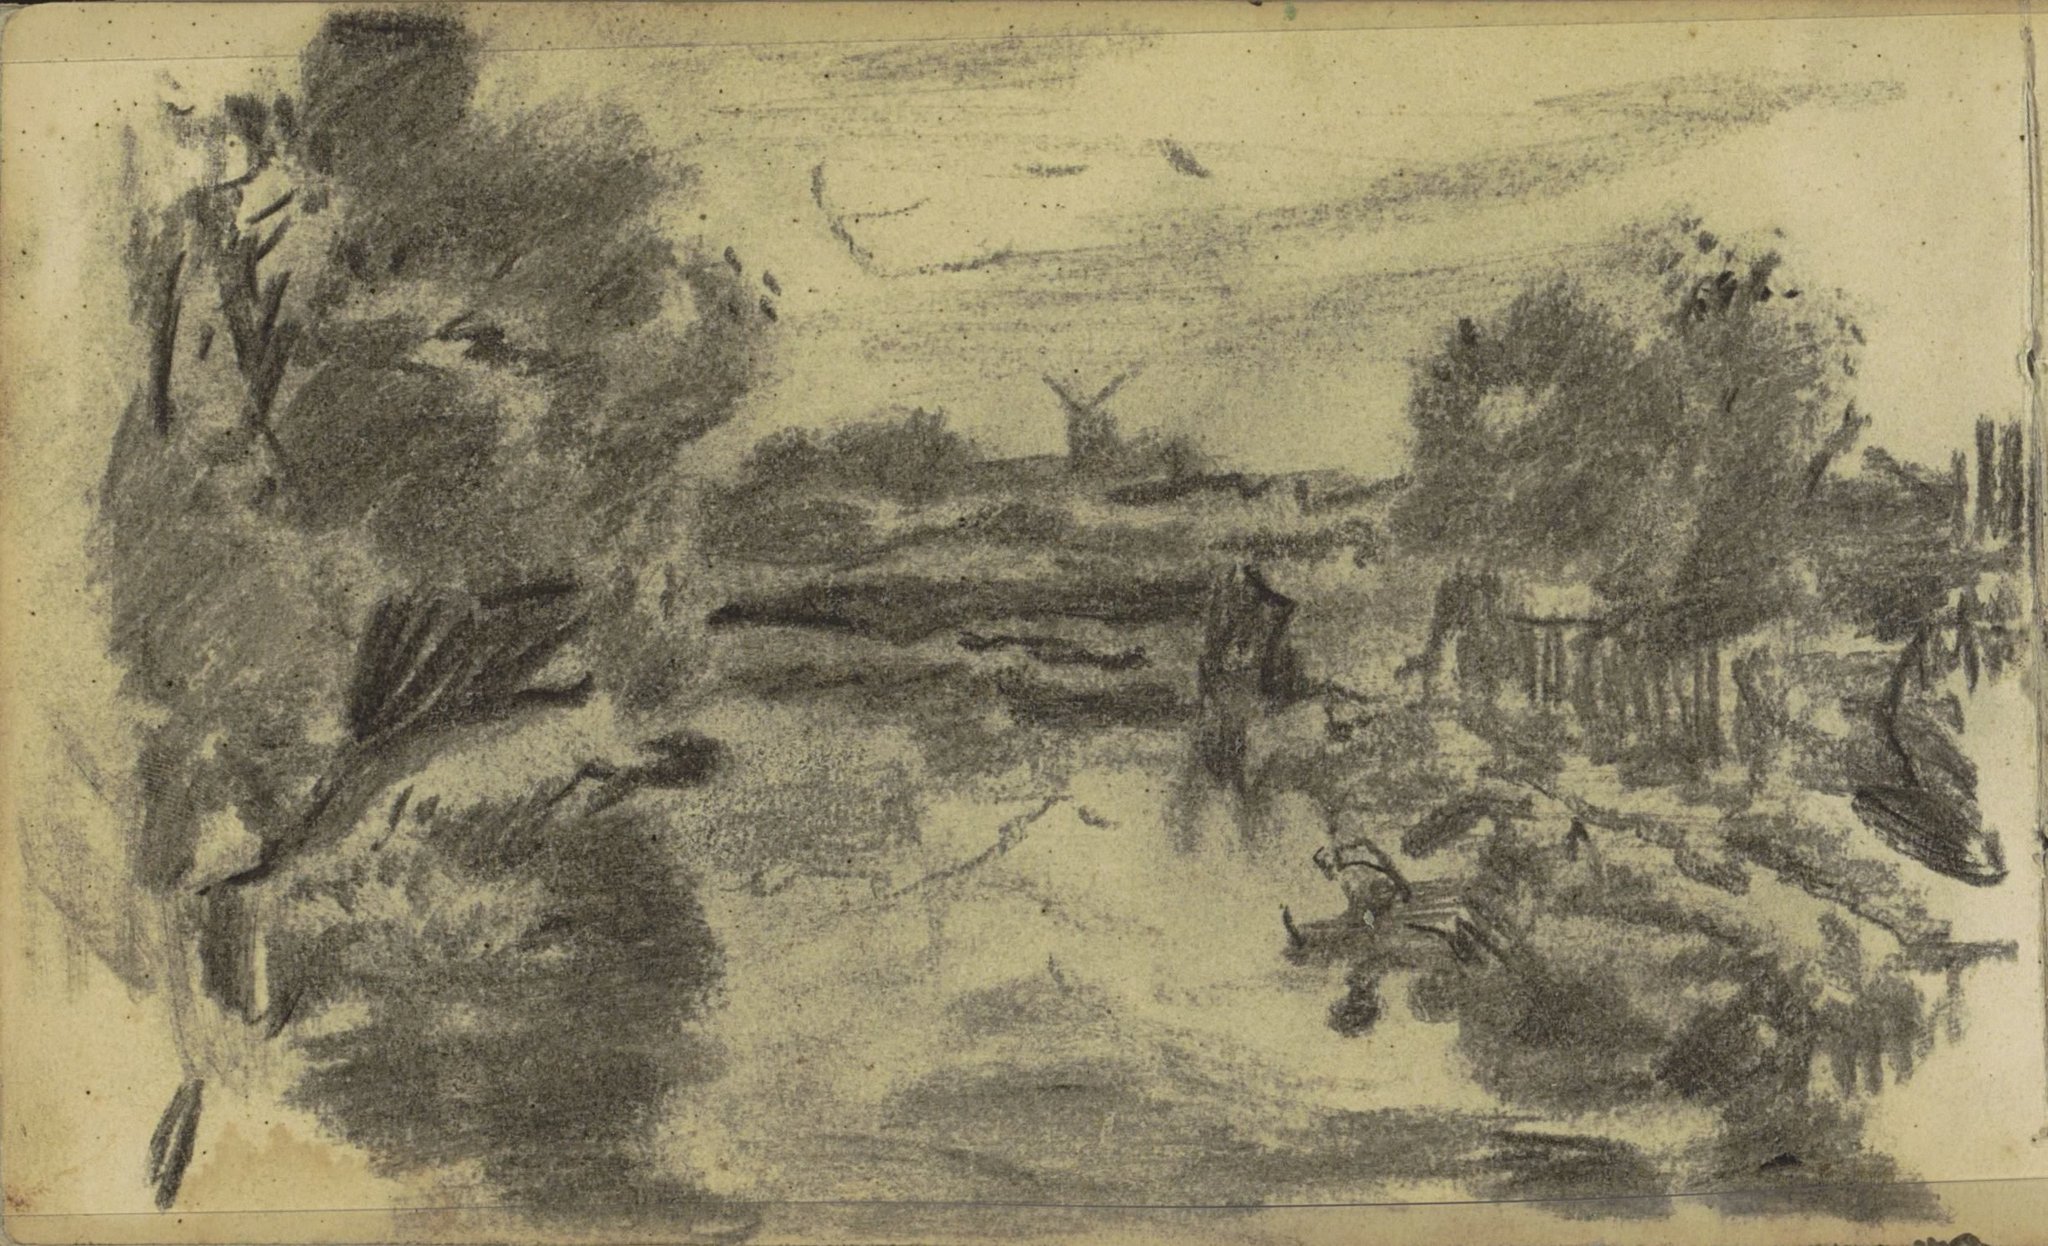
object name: sketchbook leaf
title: Landschap met water en een molen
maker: jozef israëls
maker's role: draughtsman, painter, print maker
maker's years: 1824-1911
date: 1834-1911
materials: chalk, paper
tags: landscapes with waters, waterscapes, seascapes (in the temperate zone), windmill in landscape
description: Blad 25 verso uit een schetsboek met 42 bladen.